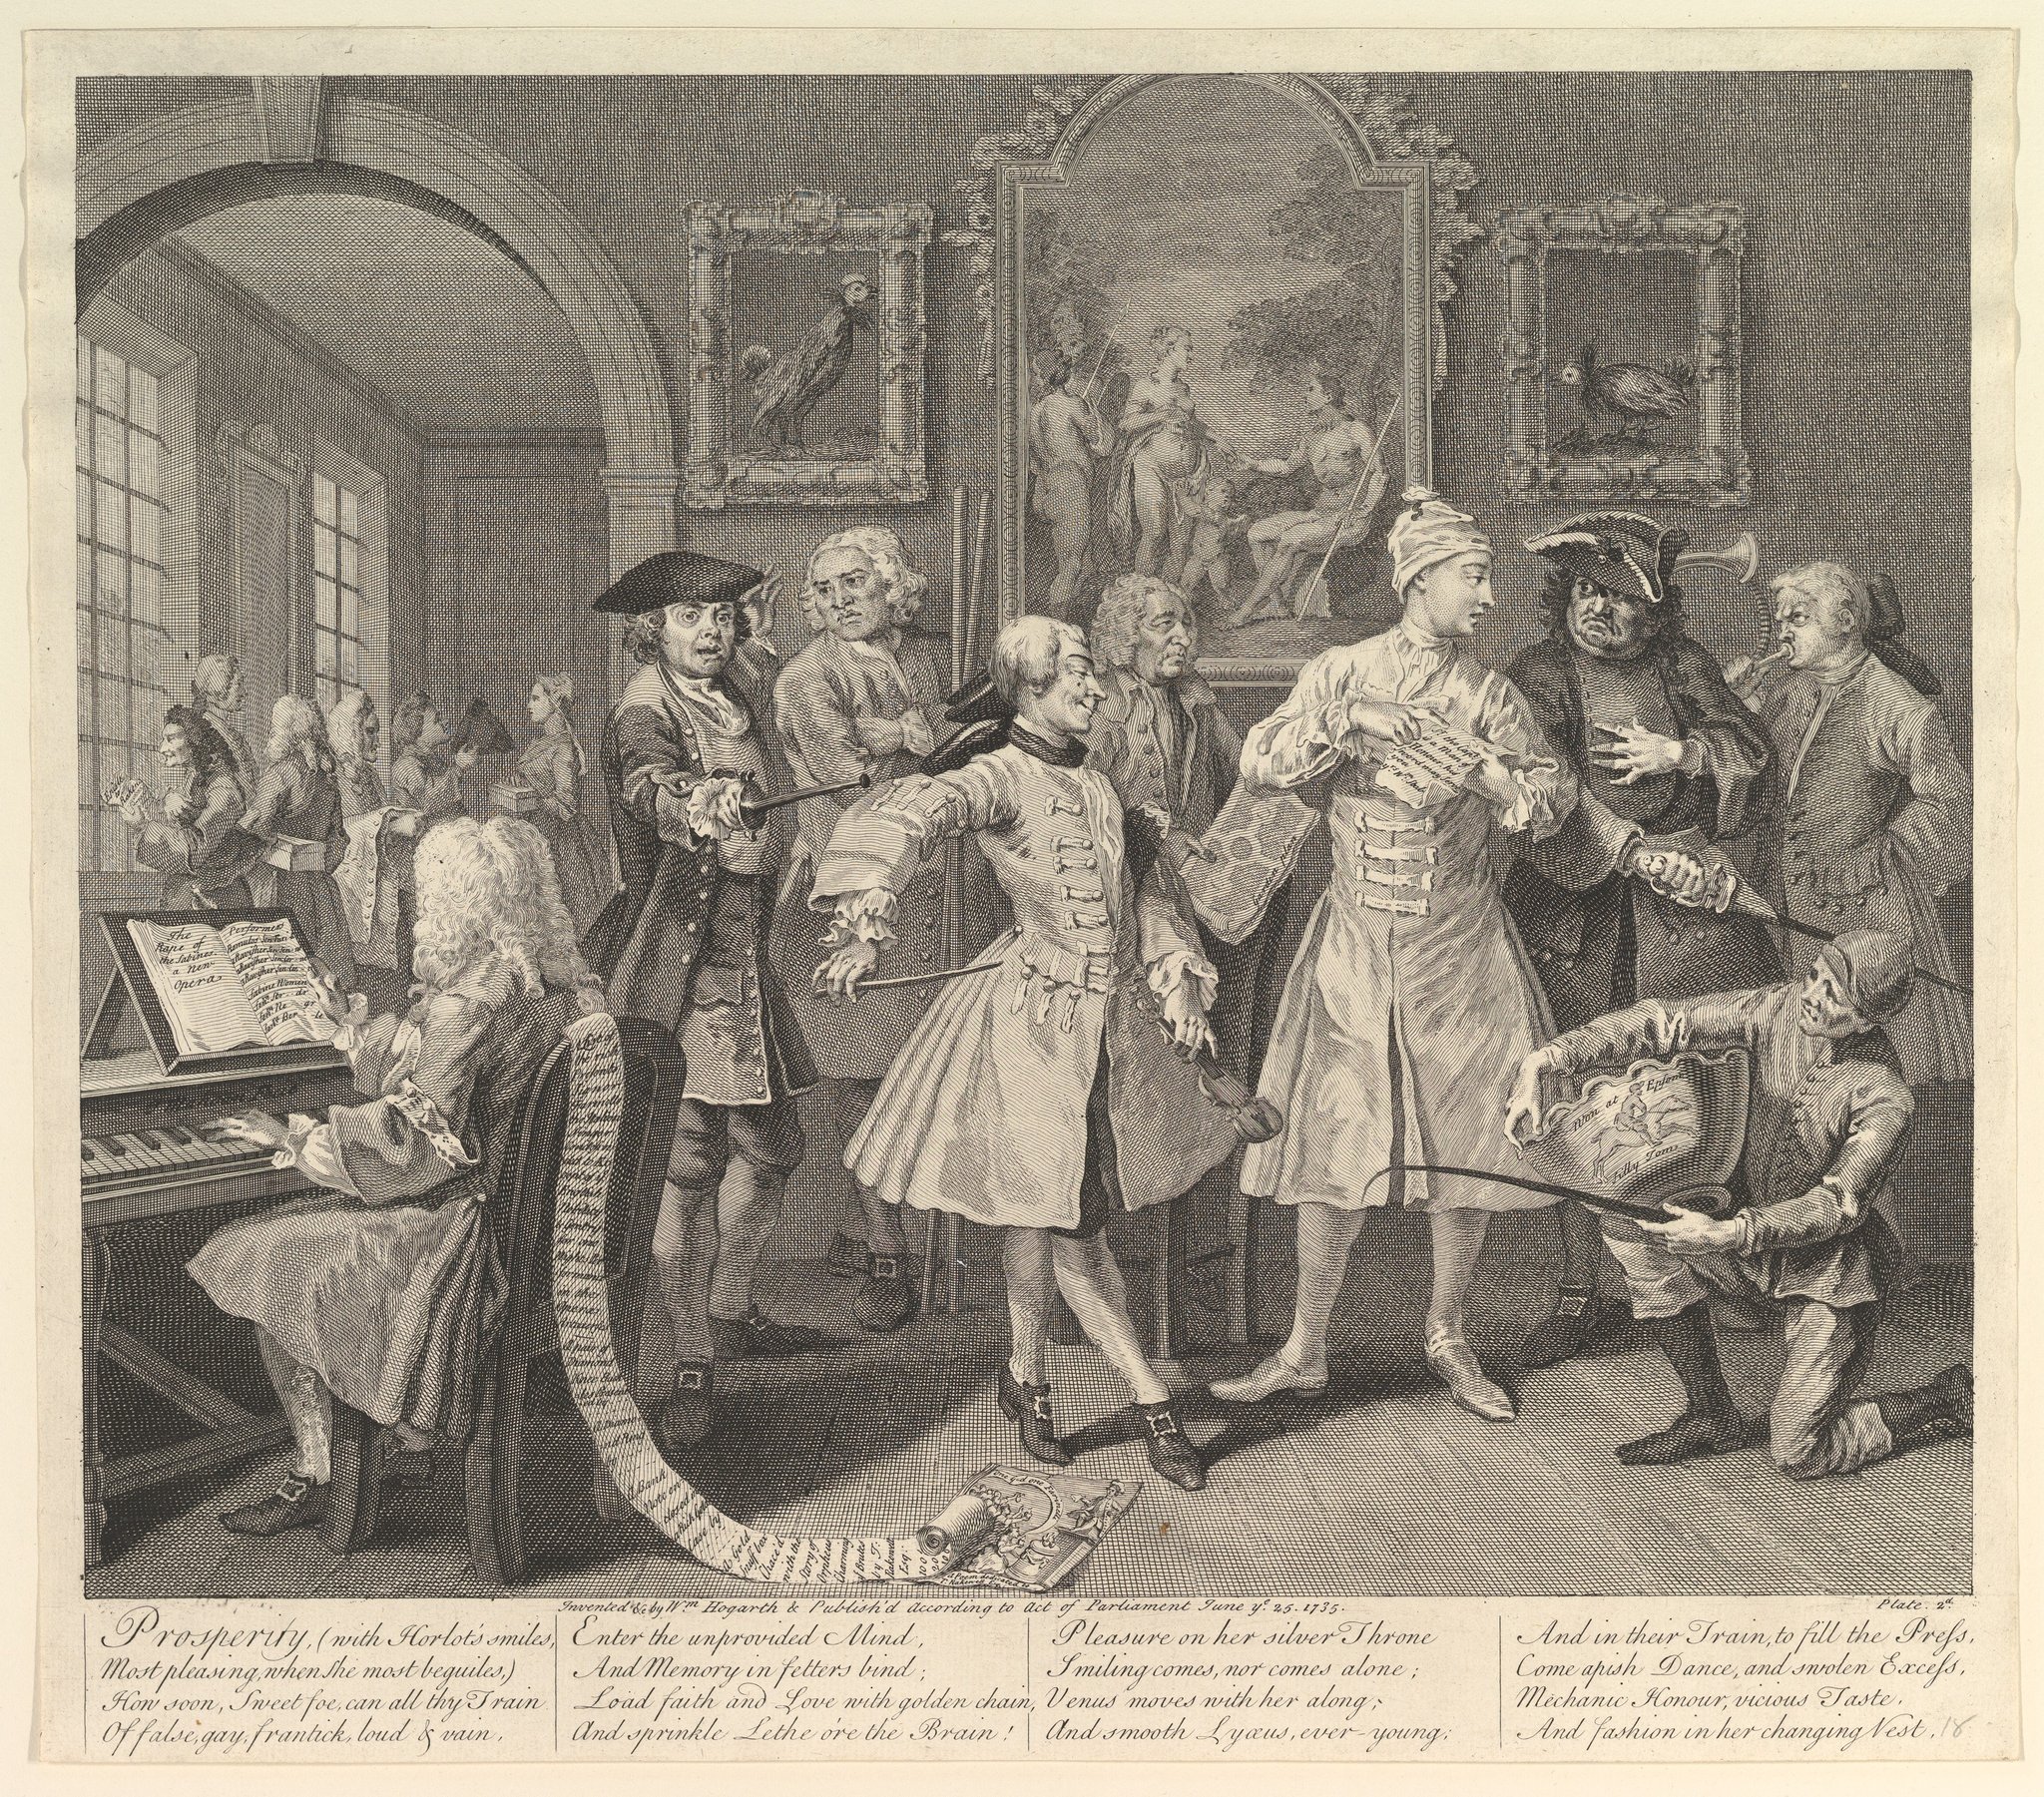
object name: print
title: A Rake's Progress, Plate 2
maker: william hogarth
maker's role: artist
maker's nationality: british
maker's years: 1697-1764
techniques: engraving, etching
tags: musical instruments,men,women